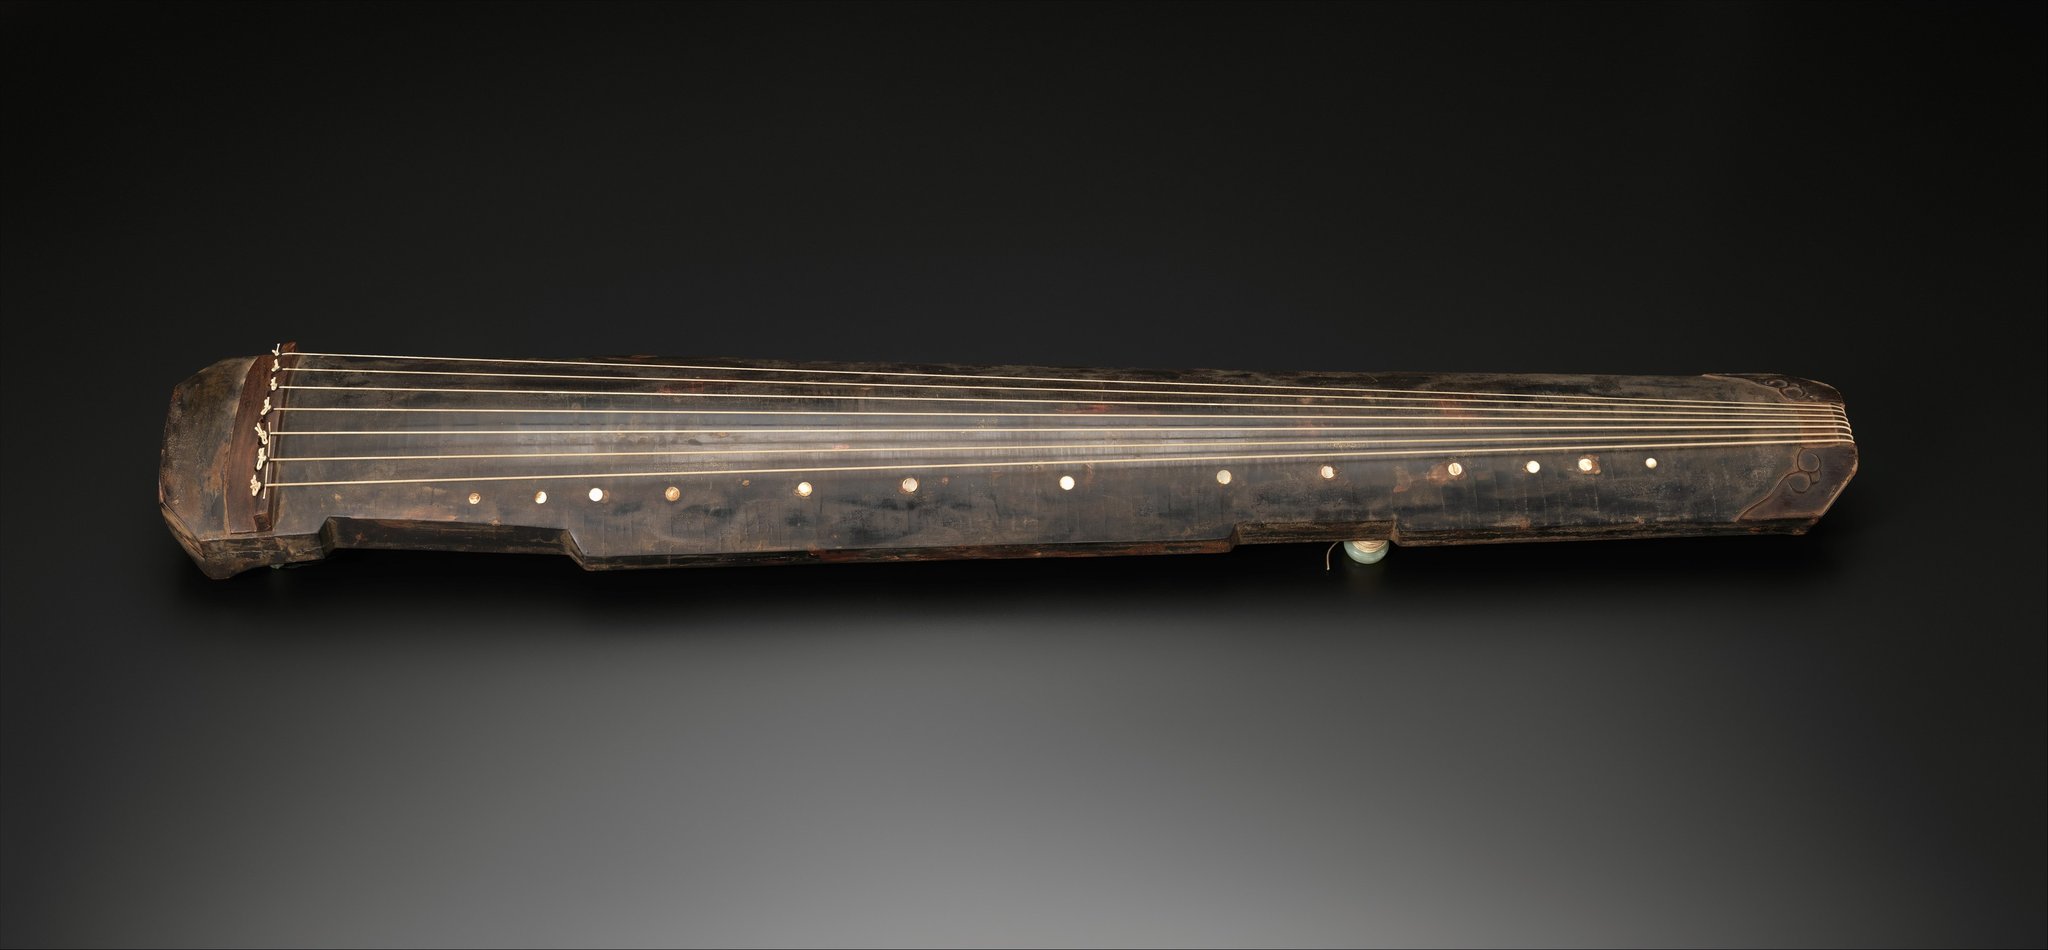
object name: qin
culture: chinese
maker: prince lu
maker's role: artist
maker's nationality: chinese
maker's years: 1628-1644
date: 1634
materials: jade, lacquer, silk, wood